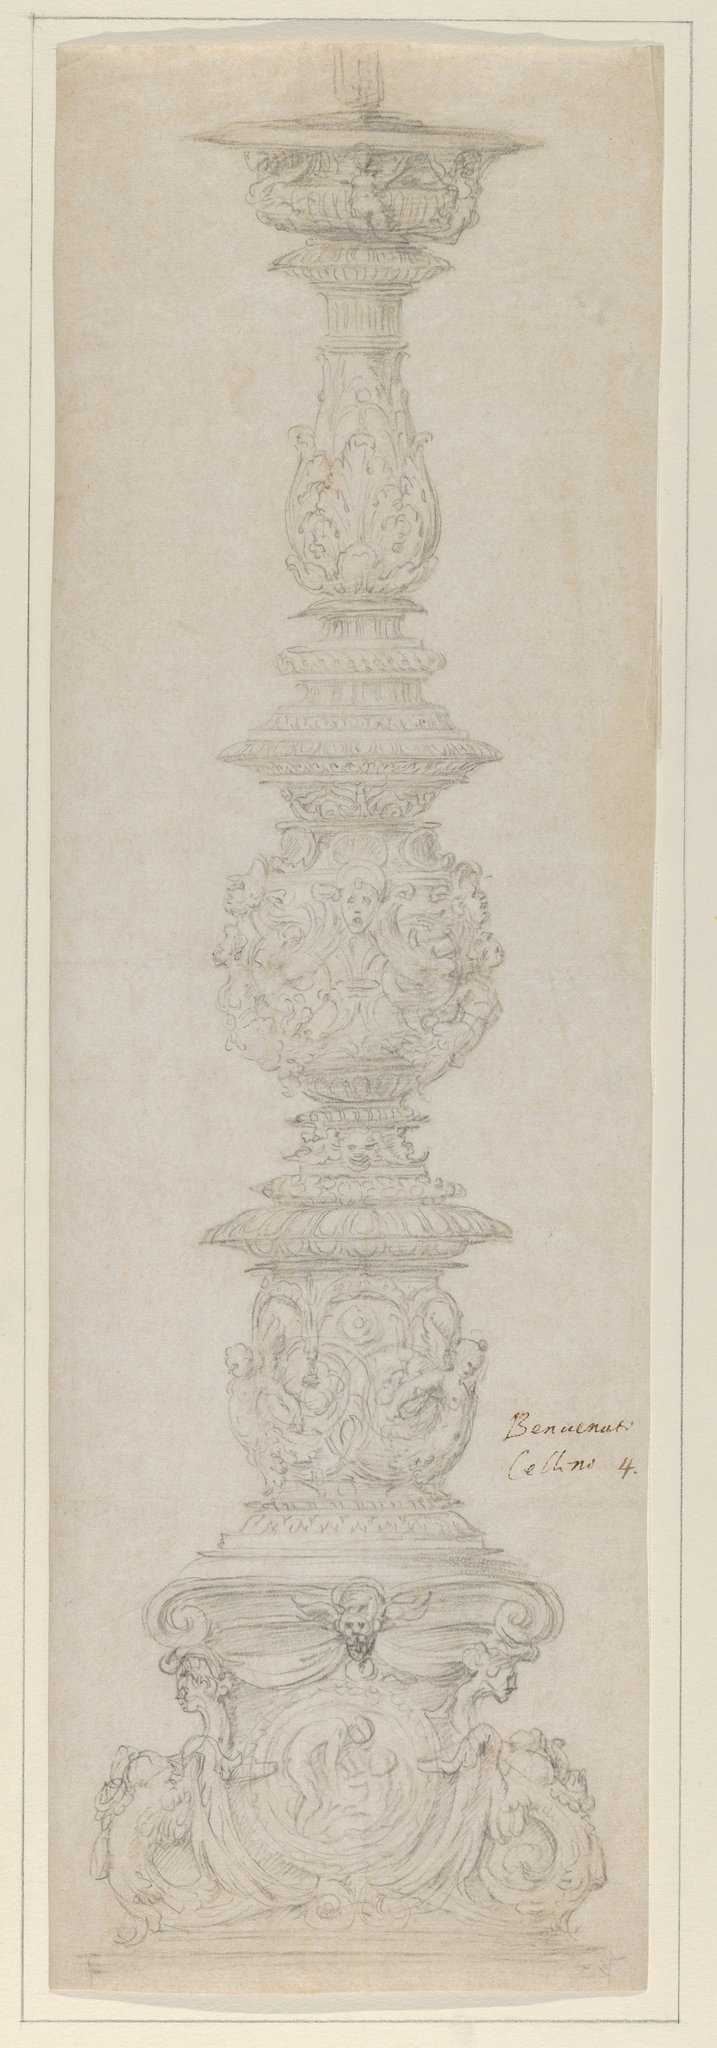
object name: drawing ornament architecture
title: Design for a Candelabra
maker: bernardo buontalenti (bernardo delle girandole)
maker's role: artist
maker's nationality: italian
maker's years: 1526-1608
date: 1550-1580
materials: chalk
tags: candelabra